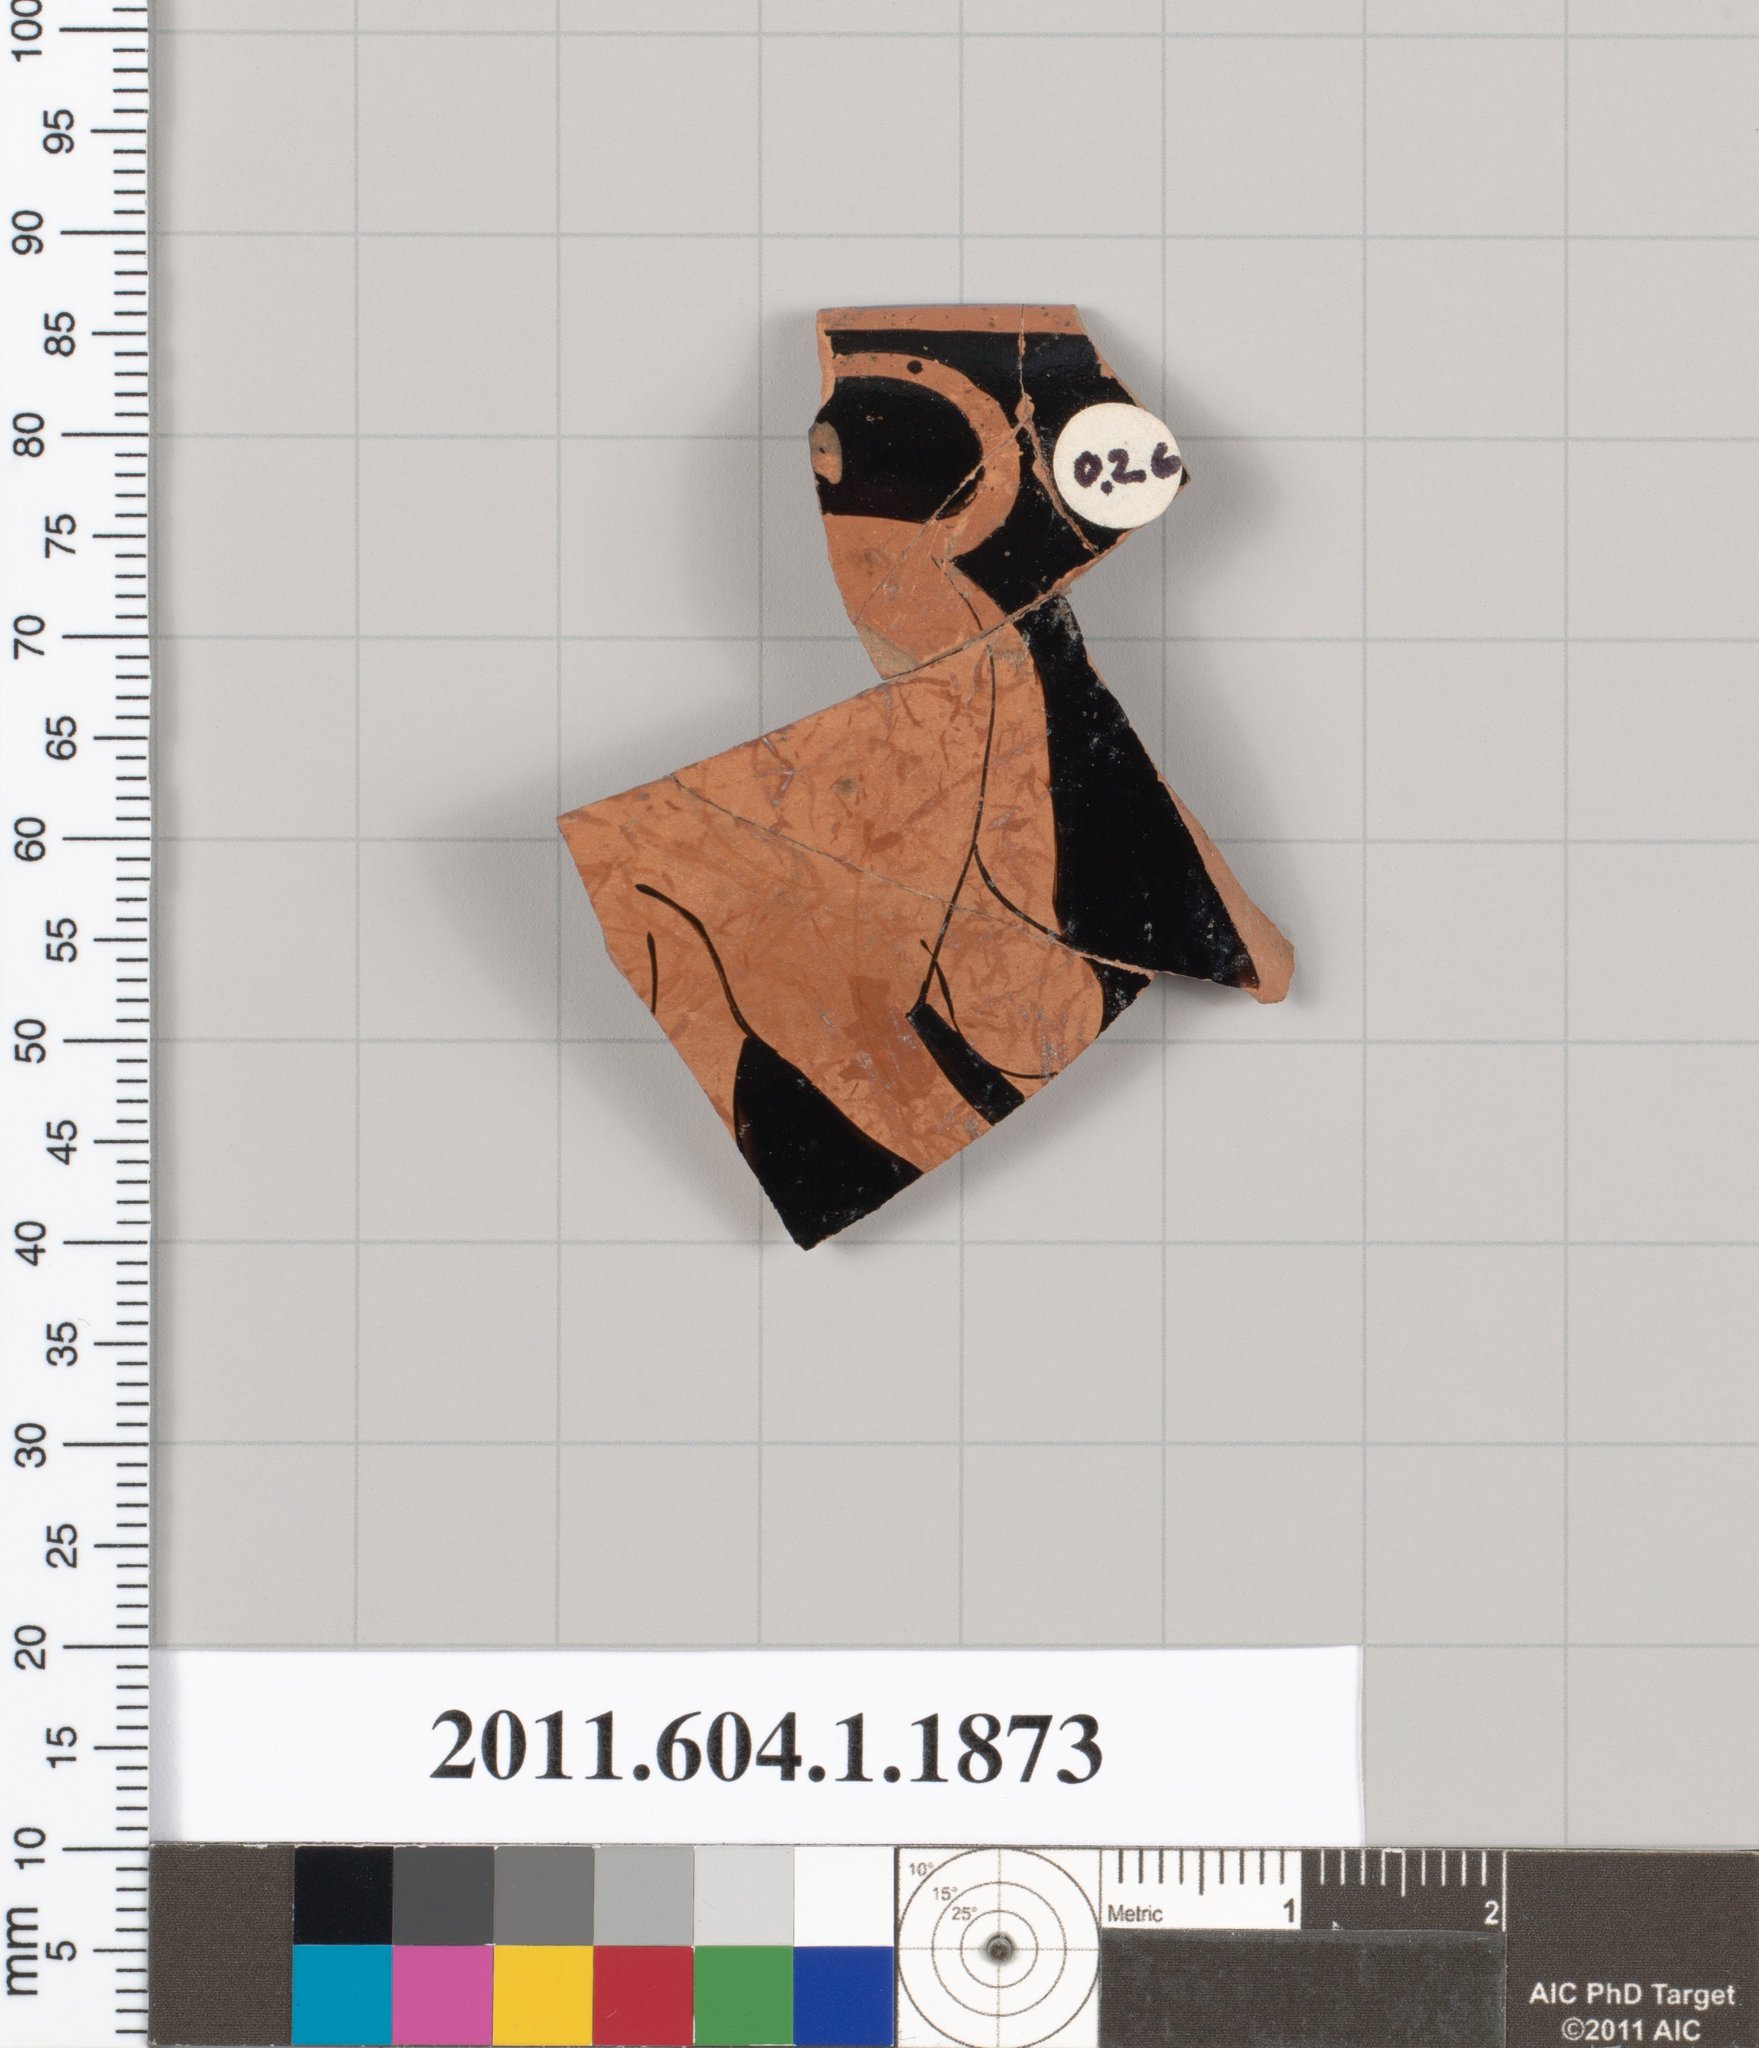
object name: kylix fragment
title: Terracotta rim fragment of a kylix (drinking cup)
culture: greek, attic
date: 490-480 BCE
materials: terracotta